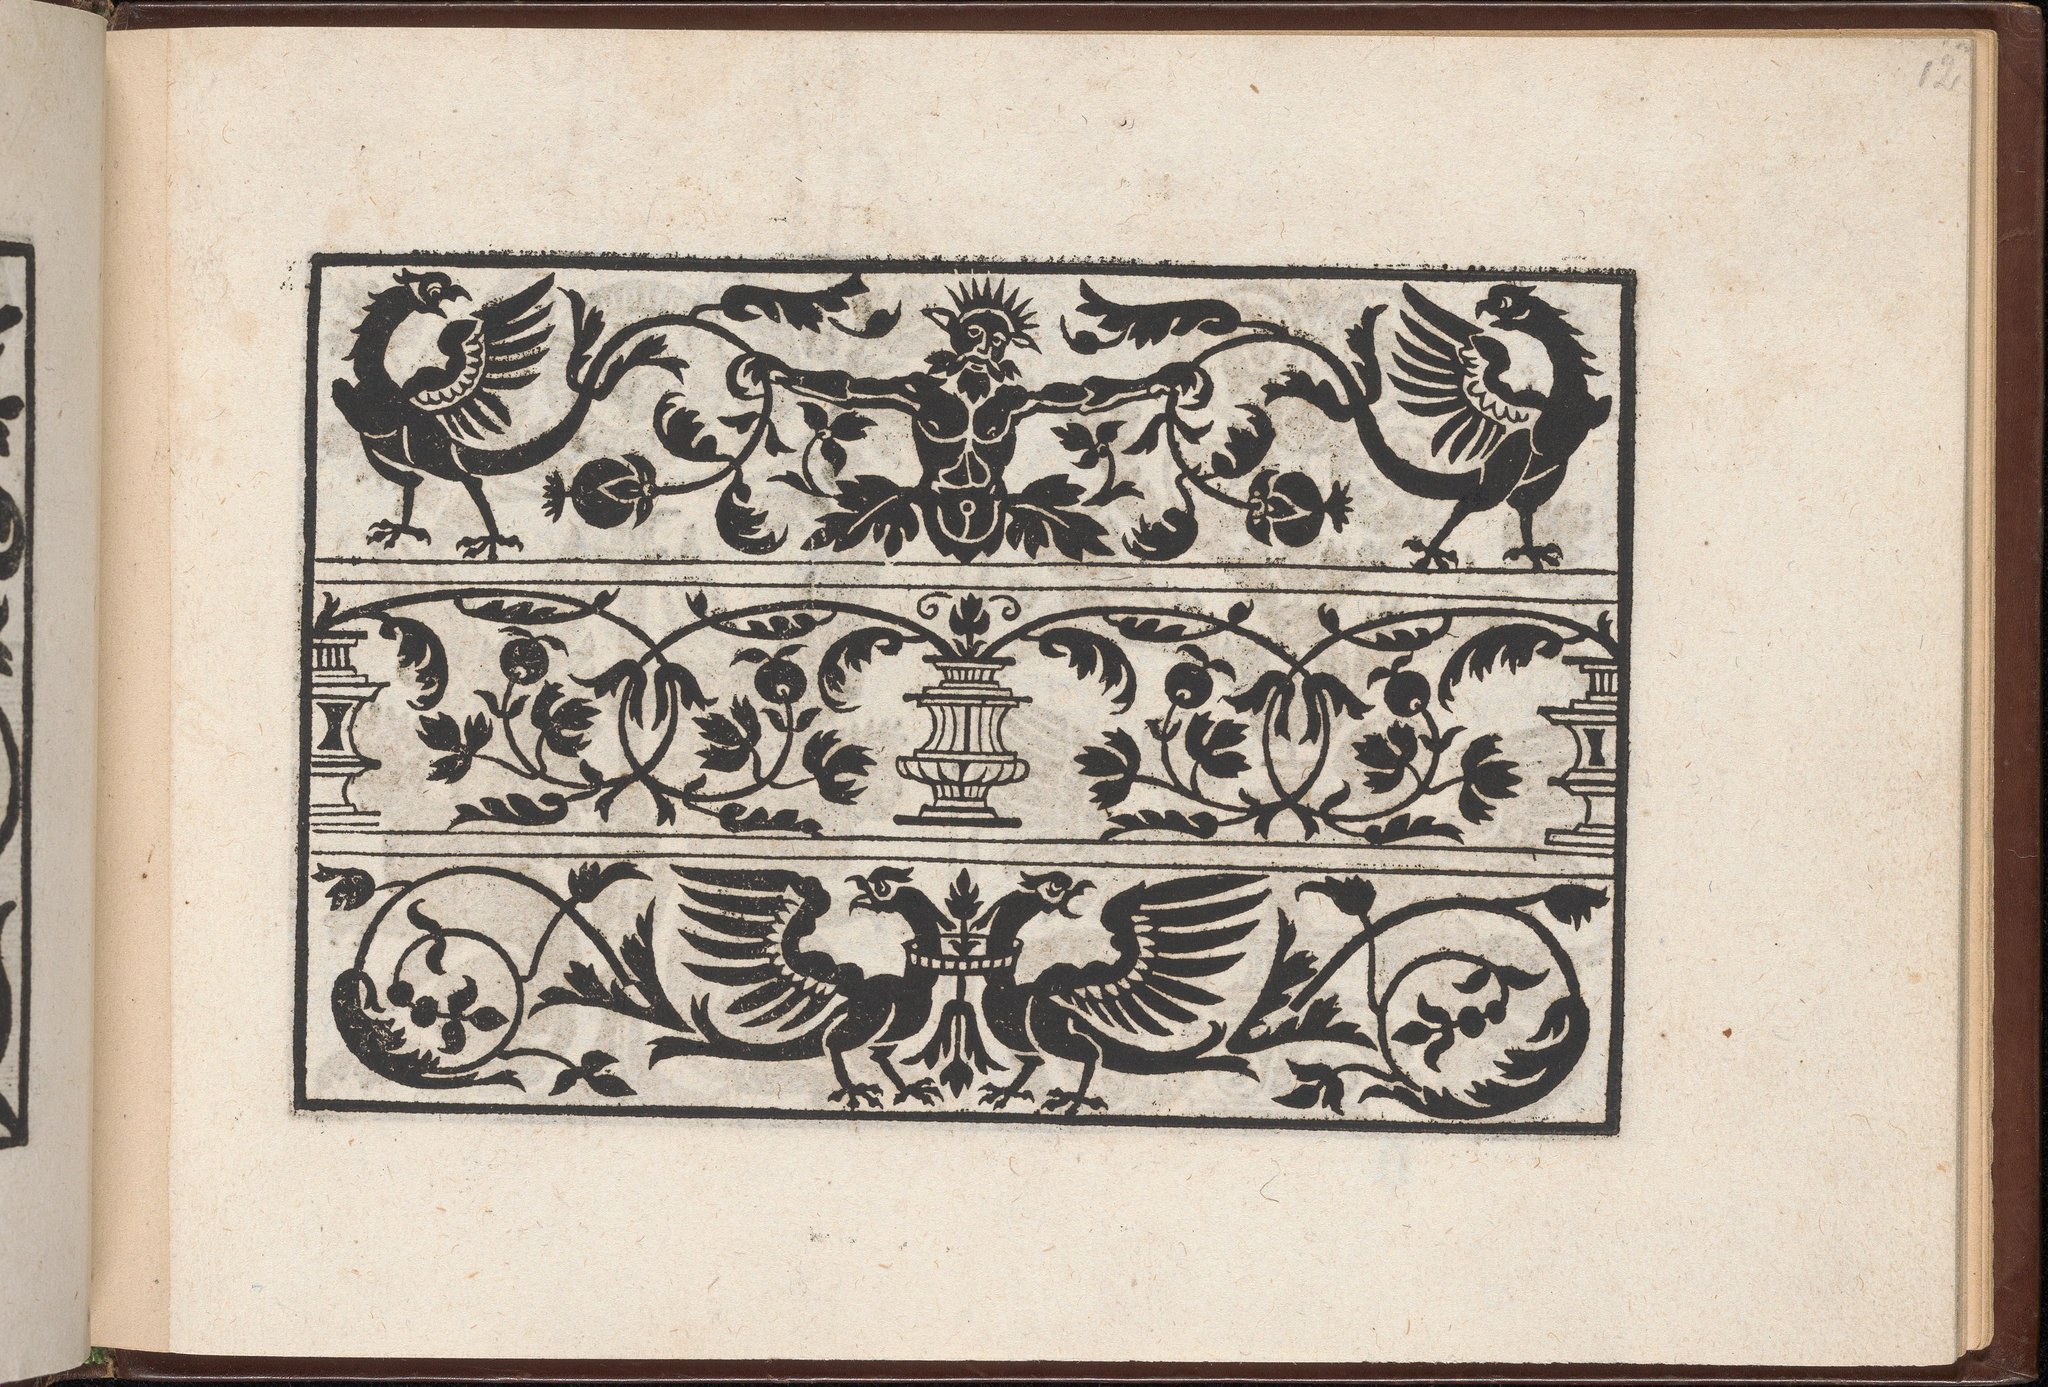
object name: book print ornament architecture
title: Page from Eyn Newe kunstlich moetdelboech alle kunst (Page 12r)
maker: peter quentel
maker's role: publisher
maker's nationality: german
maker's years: 1500-1550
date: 1532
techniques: woodcut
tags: ornament,griffins